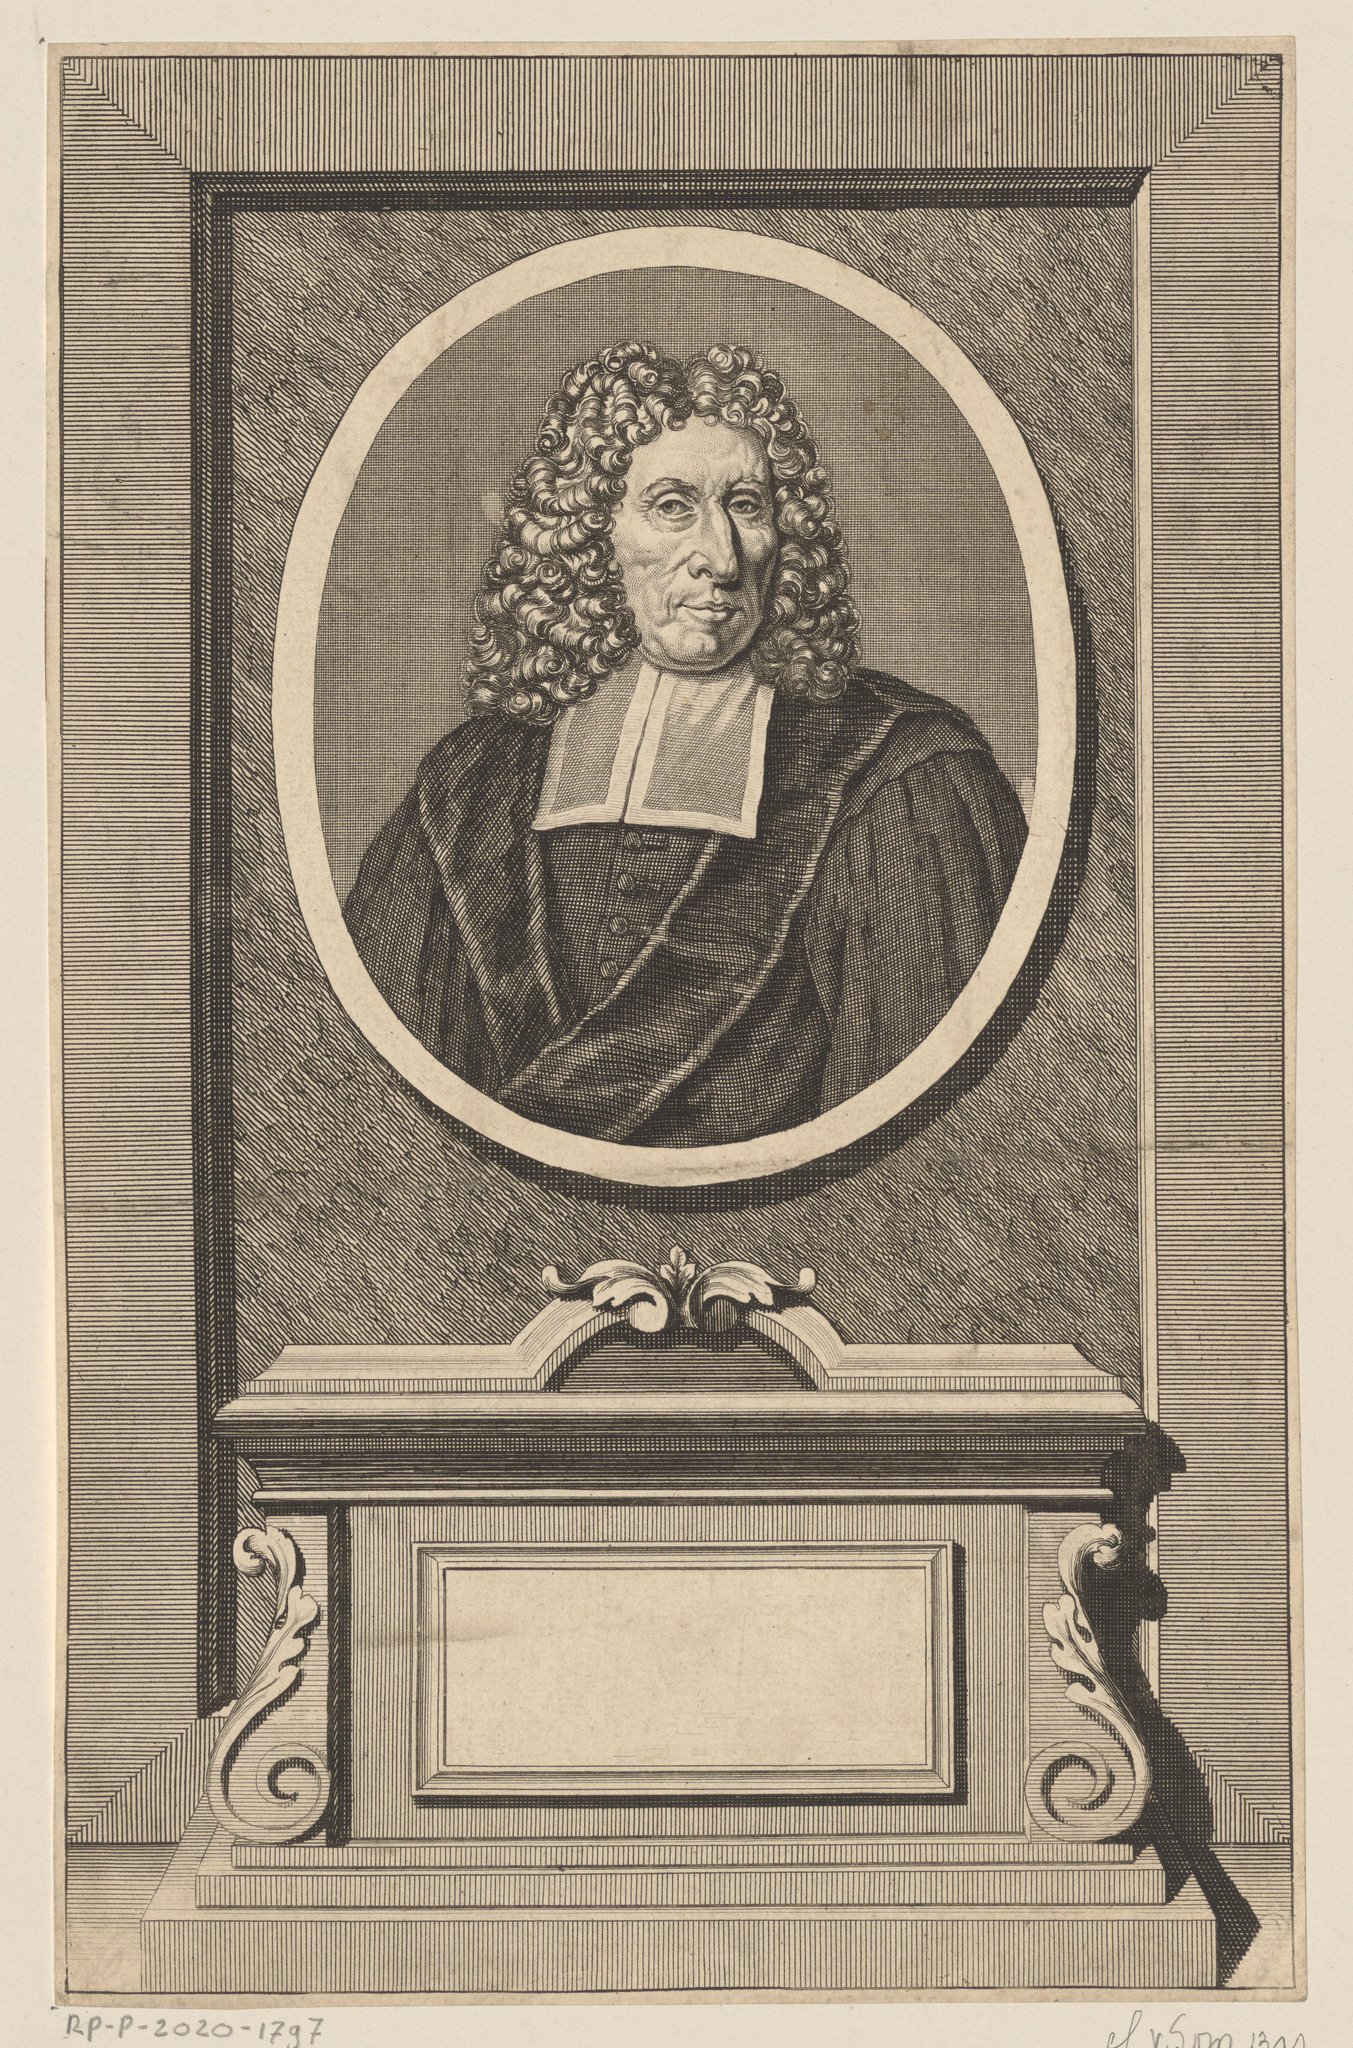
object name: print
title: Portret van Frederik Dekkers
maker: Anonymous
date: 1716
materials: paper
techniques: engraving, etching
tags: leiden, historical persons, scholastic education, tuition (+ teacher, professor), physician, doctor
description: Latere staat van prent gebruikt in: Fundatoris curatorum et professorum celeberrimorum, (...) academia Lugduno-Batava (...). Leiden: Pieter vander Aa, [ca. 1716].